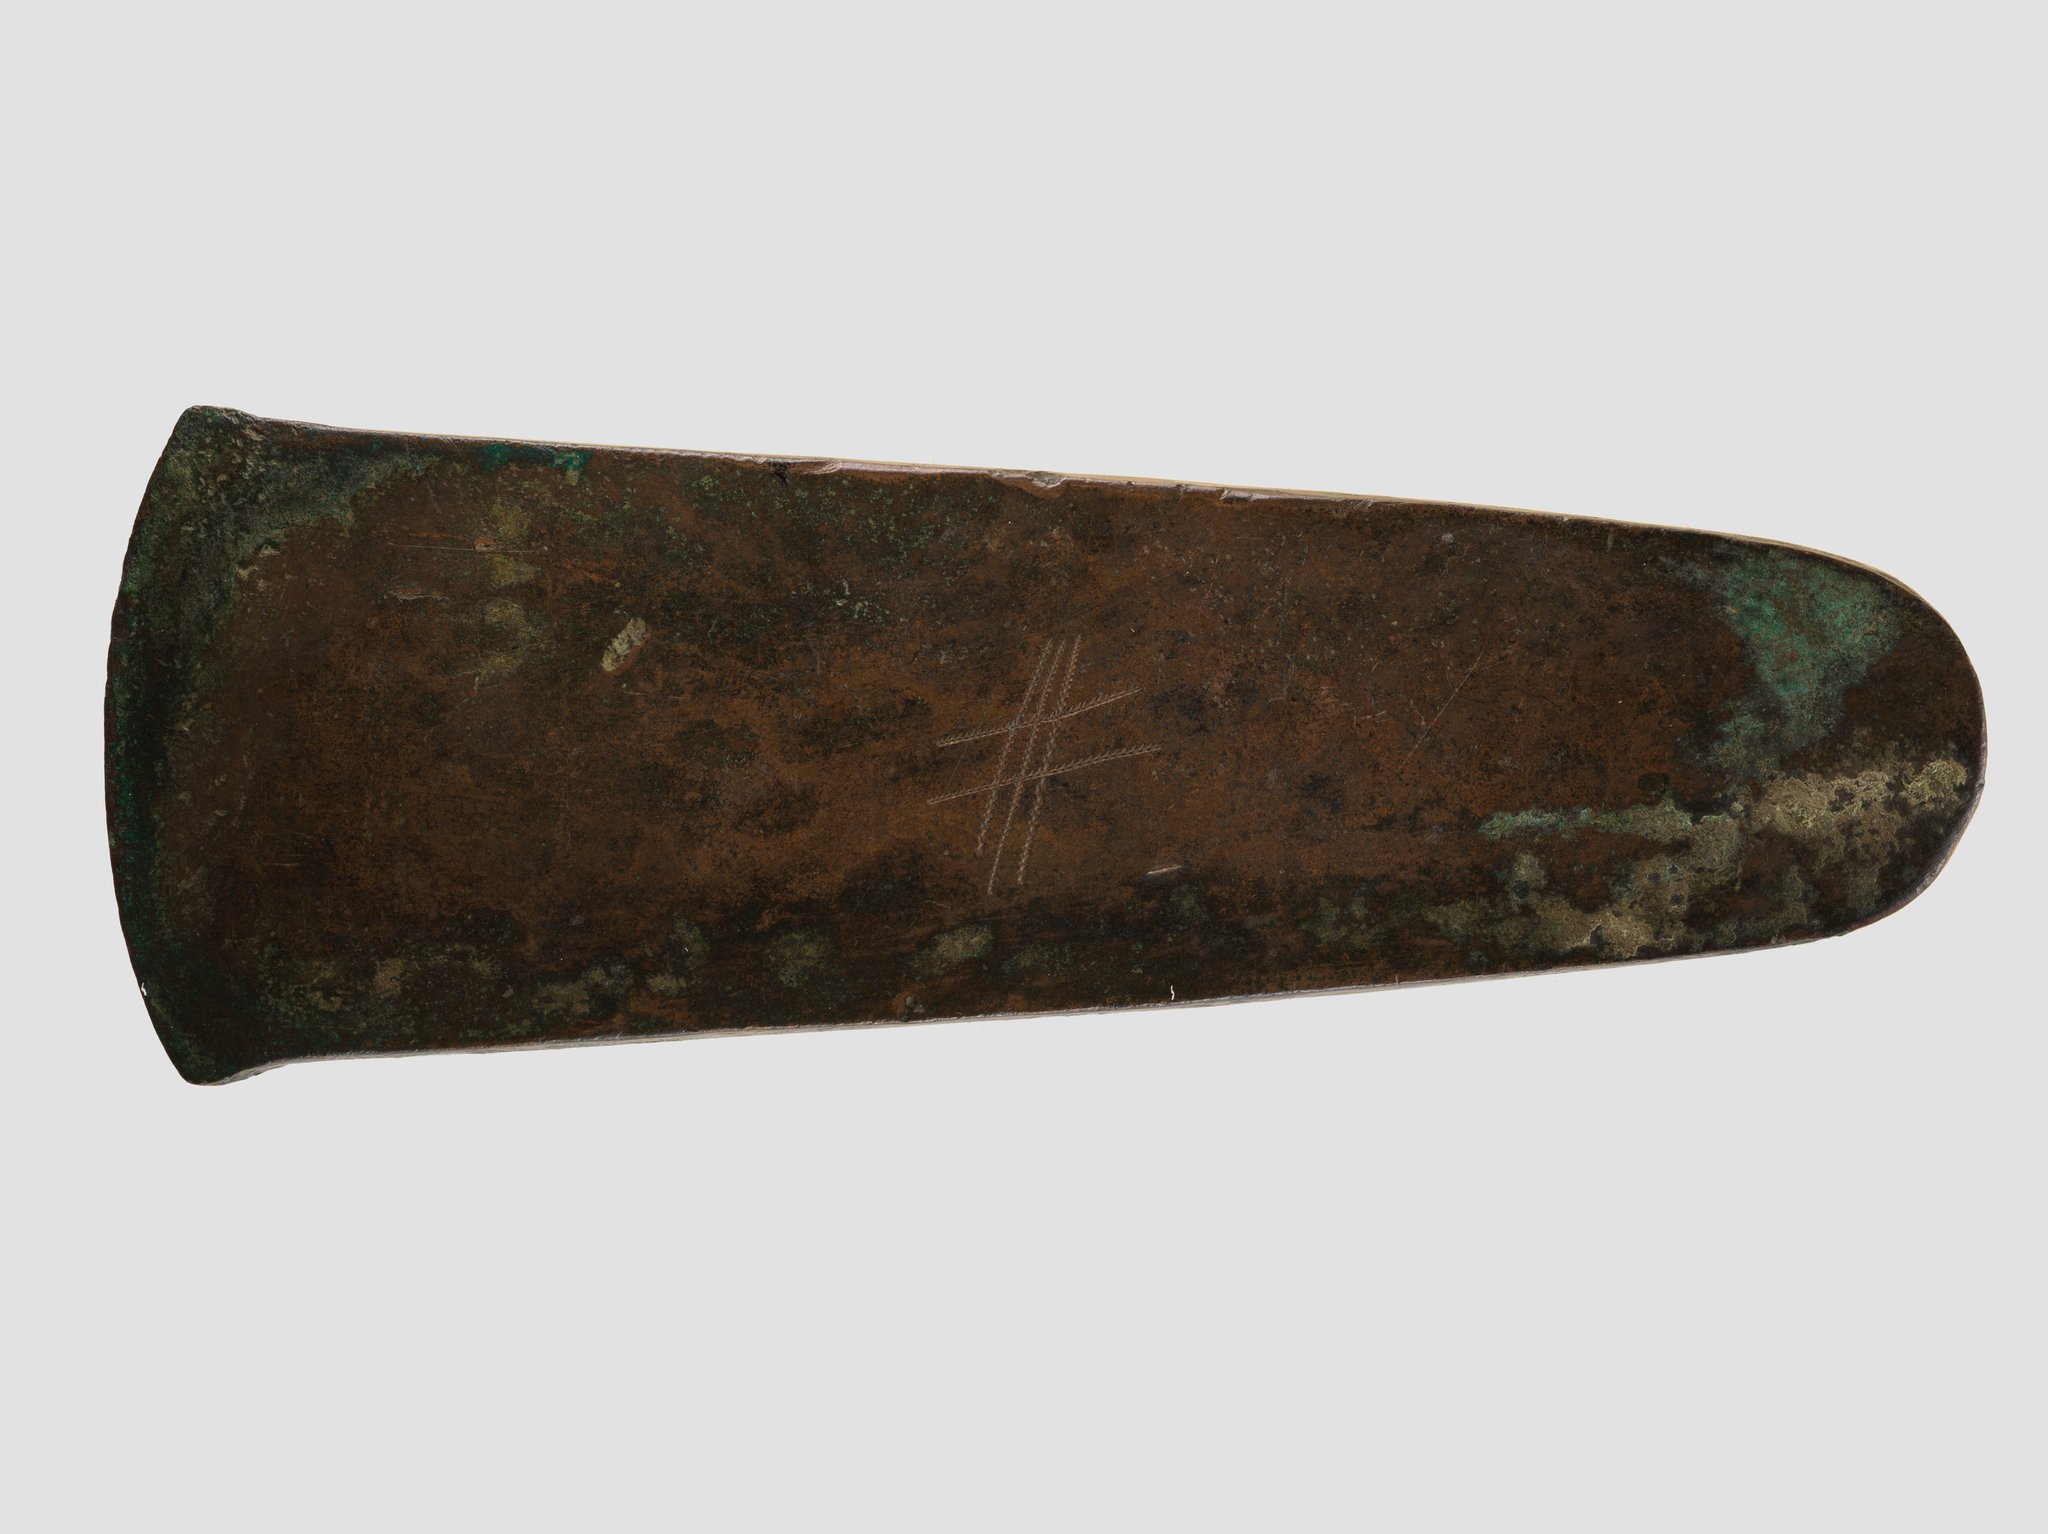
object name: axe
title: Axe head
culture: hattian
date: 2300-2000 BCE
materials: bronze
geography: central anatolia